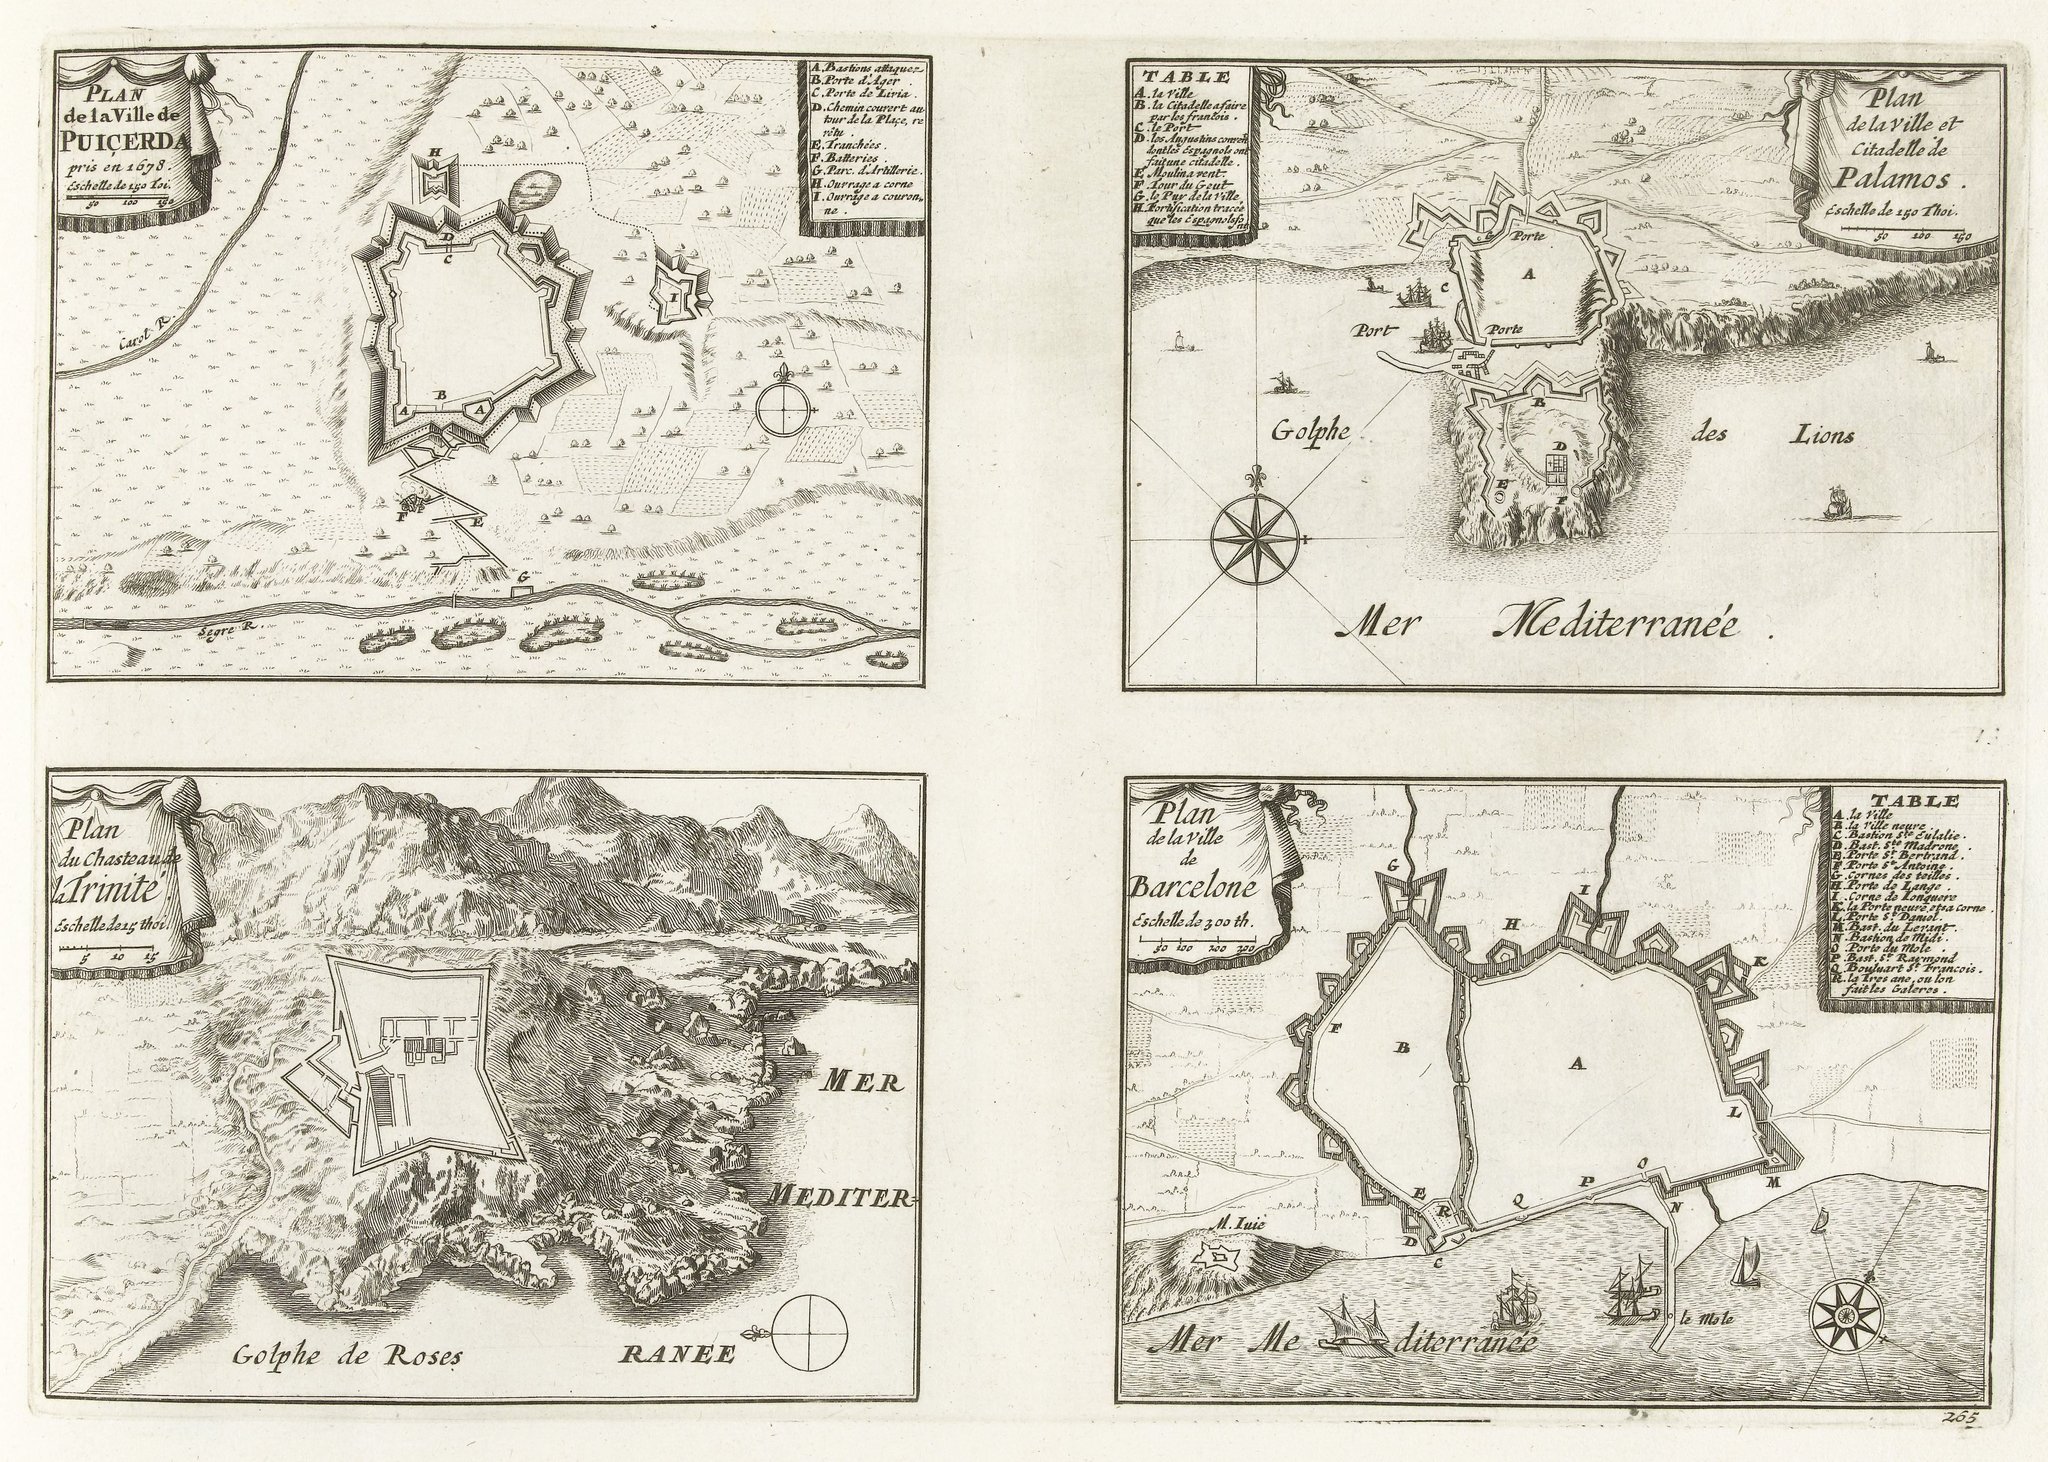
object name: print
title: Plattegronden van Puigcerdá, Palamos, Château de la Trinité en Barcelona, ca. 1702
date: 1702-1703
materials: paper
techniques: etching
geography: amsterdam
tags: fortress, maps of cities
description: Blad met vier plattegronden van de versterkingen om de Spaanse steden Puigcerdá, Palamos, Château de la Trinité en Barcelona. Plaat nr. 265 in het prentwerk bestaande in totaal uit 276 genummerde platen van vermaarde sterke steden en vestingen in het kader van de Spaanse Successieoorlog. Voor het merendeel zijn deze platen gekopieerd naar de anonieme Franse platen: in Les forces de l'Europe en in: Le theatre de la guerre, dans les Pays-Bas, beide oorspronkelijk uitgegeven door Nicolas de Fer te Parijs (1693-1697) in het kader van de Negenjarige Oorlog. Titels en opschriften in de plaat in het Frans.